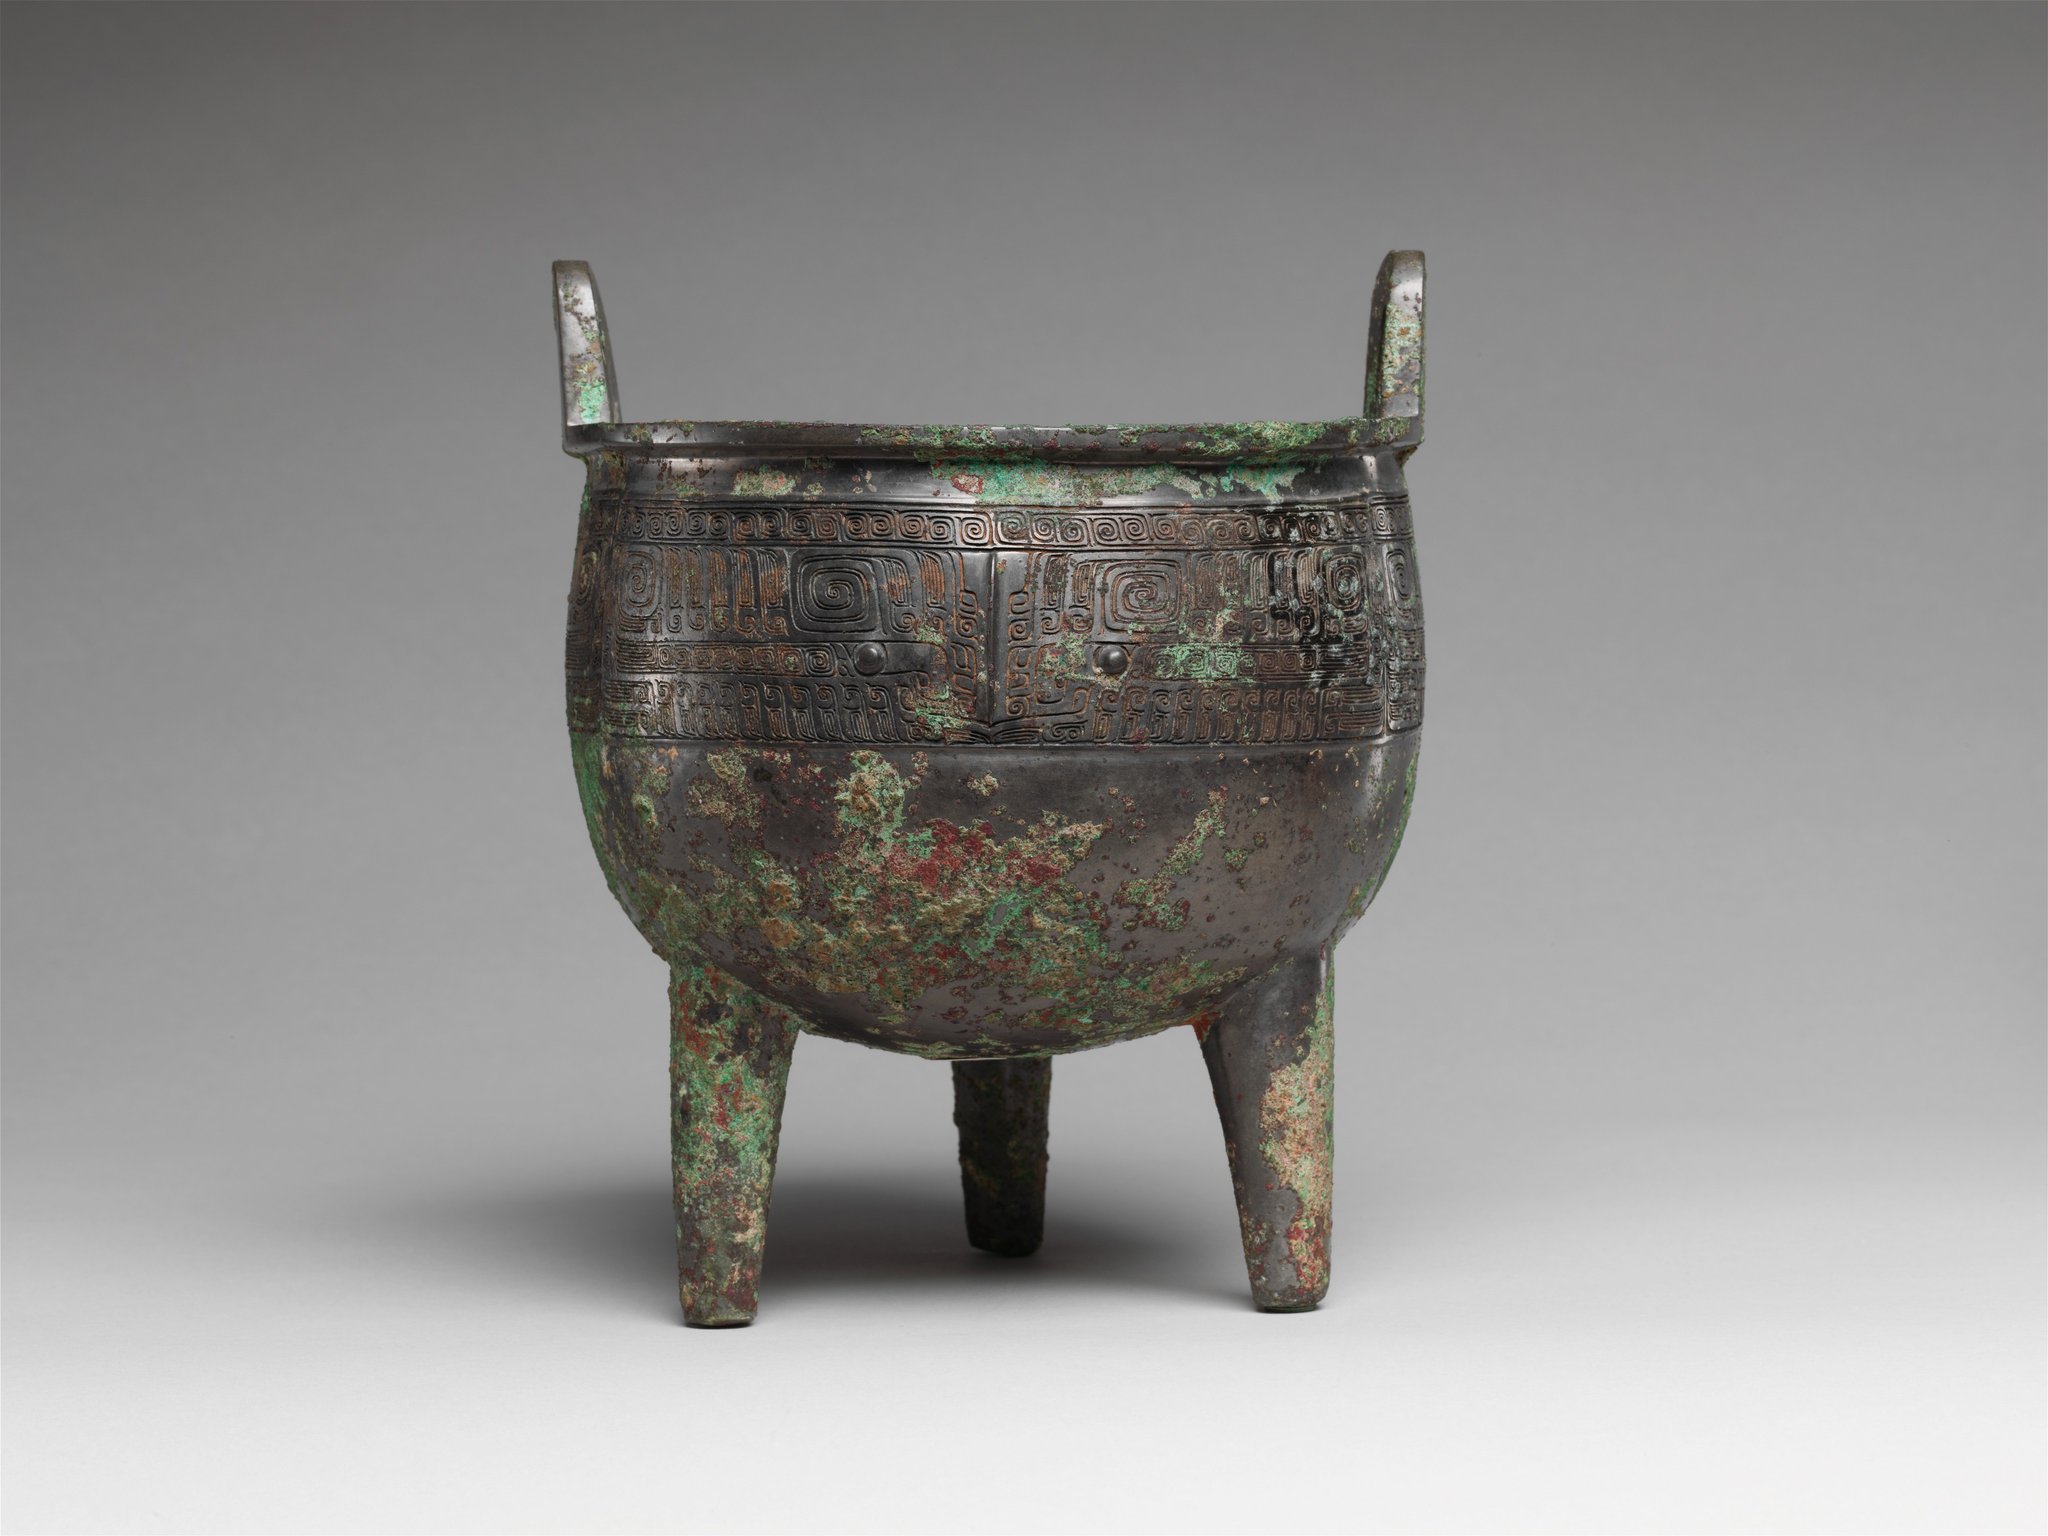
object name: cauldron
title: Tripod cauldron (Ding)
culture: chinese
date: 1300-1101 BCE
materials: bronze